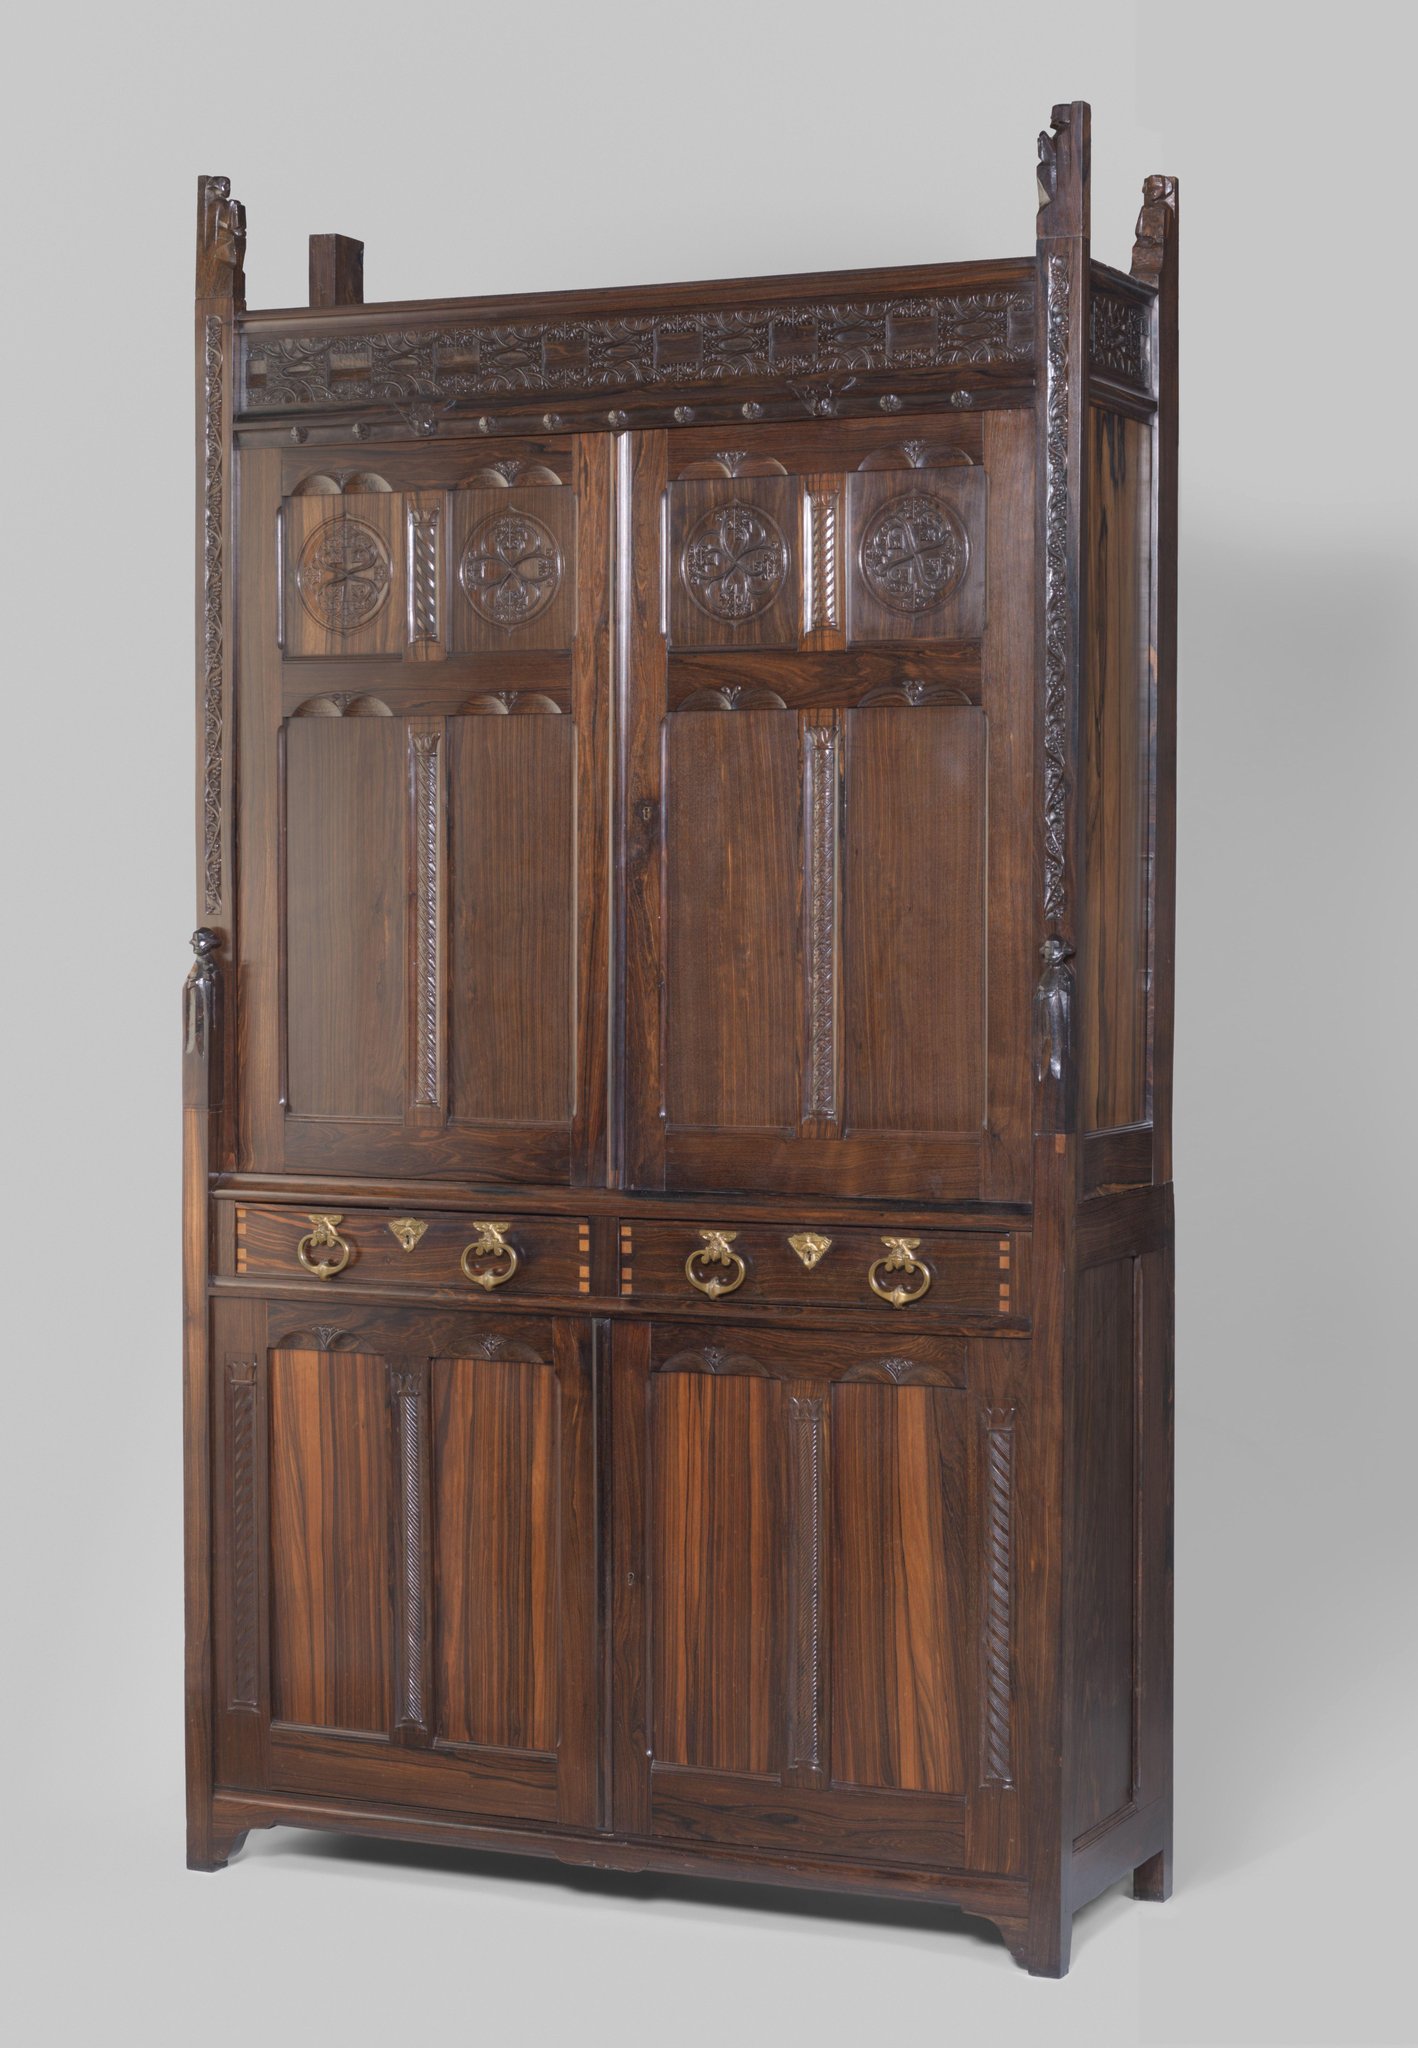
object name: case furniture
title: Kast bestaande uit een onderkast en licht terugwijkende bovenkast met hoekstijlen die eindigen in gebeeldhouwde figuren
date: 1910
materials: brass, wood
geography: amsterdam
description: Kast van coromandelhout bestaande uit een onder- en een licht terugwijkende bovenkast. De onderkast heeft twee deuren met daarboven twee laden. De deuren bestaan elk uit panelen binnen een raamwerk waarvan de stijlen gesneden zuilen met bladkapitelen bevatten. Zowel op de linker- als de rechterzijden van de laden zijn de eikenhouten uiteinden van de zwaluwstaartverbindingen van de ladeconstructie te zien, namelijk drie vierkanten boven elkaar. De laden bevat koperbeslag in de vorm van sleutelplaten en hengels met maskerons. De hoekstijlen aan de voorzijde van de kast eindigen ter hoogte van het midden in een gebeeldhouwd figuur met staf. De licht terugwijkende bovenkast bestaat uit twee deuren met daarboven een kap bestaande uit twee lijsten. De deuren bestaan uit elk vier panelen waarvan de twee aan de onderzijde circa drie keer zo groot zijn als de twee aan de bovenzijde. De panelen aan de bovenzijde bevatten een toogversiering met gestileerde ranken. De panelen bevinden zich binnen een raamwerk waarvan de twee middenstijlen gesneden zuilen bevatten. Boven elke regel is een toogversiering met een maskeron. De onderste lijst van de kap bevat gebeeldhouwde rozetten en twee runderkoppen. De lijst daarboven bevat gesneden ranken en loopt door langs de zijwanden. De hoekstijlen aan de voorzijde van de bovenkast bevatten gesneden blad- en vruchtmotieven en eindigen in een gebeeldhouwd figuur met boek. Alleen de linker hoekstijl aan de achterzijde eindigt in een gebeeldhouwd figuur.